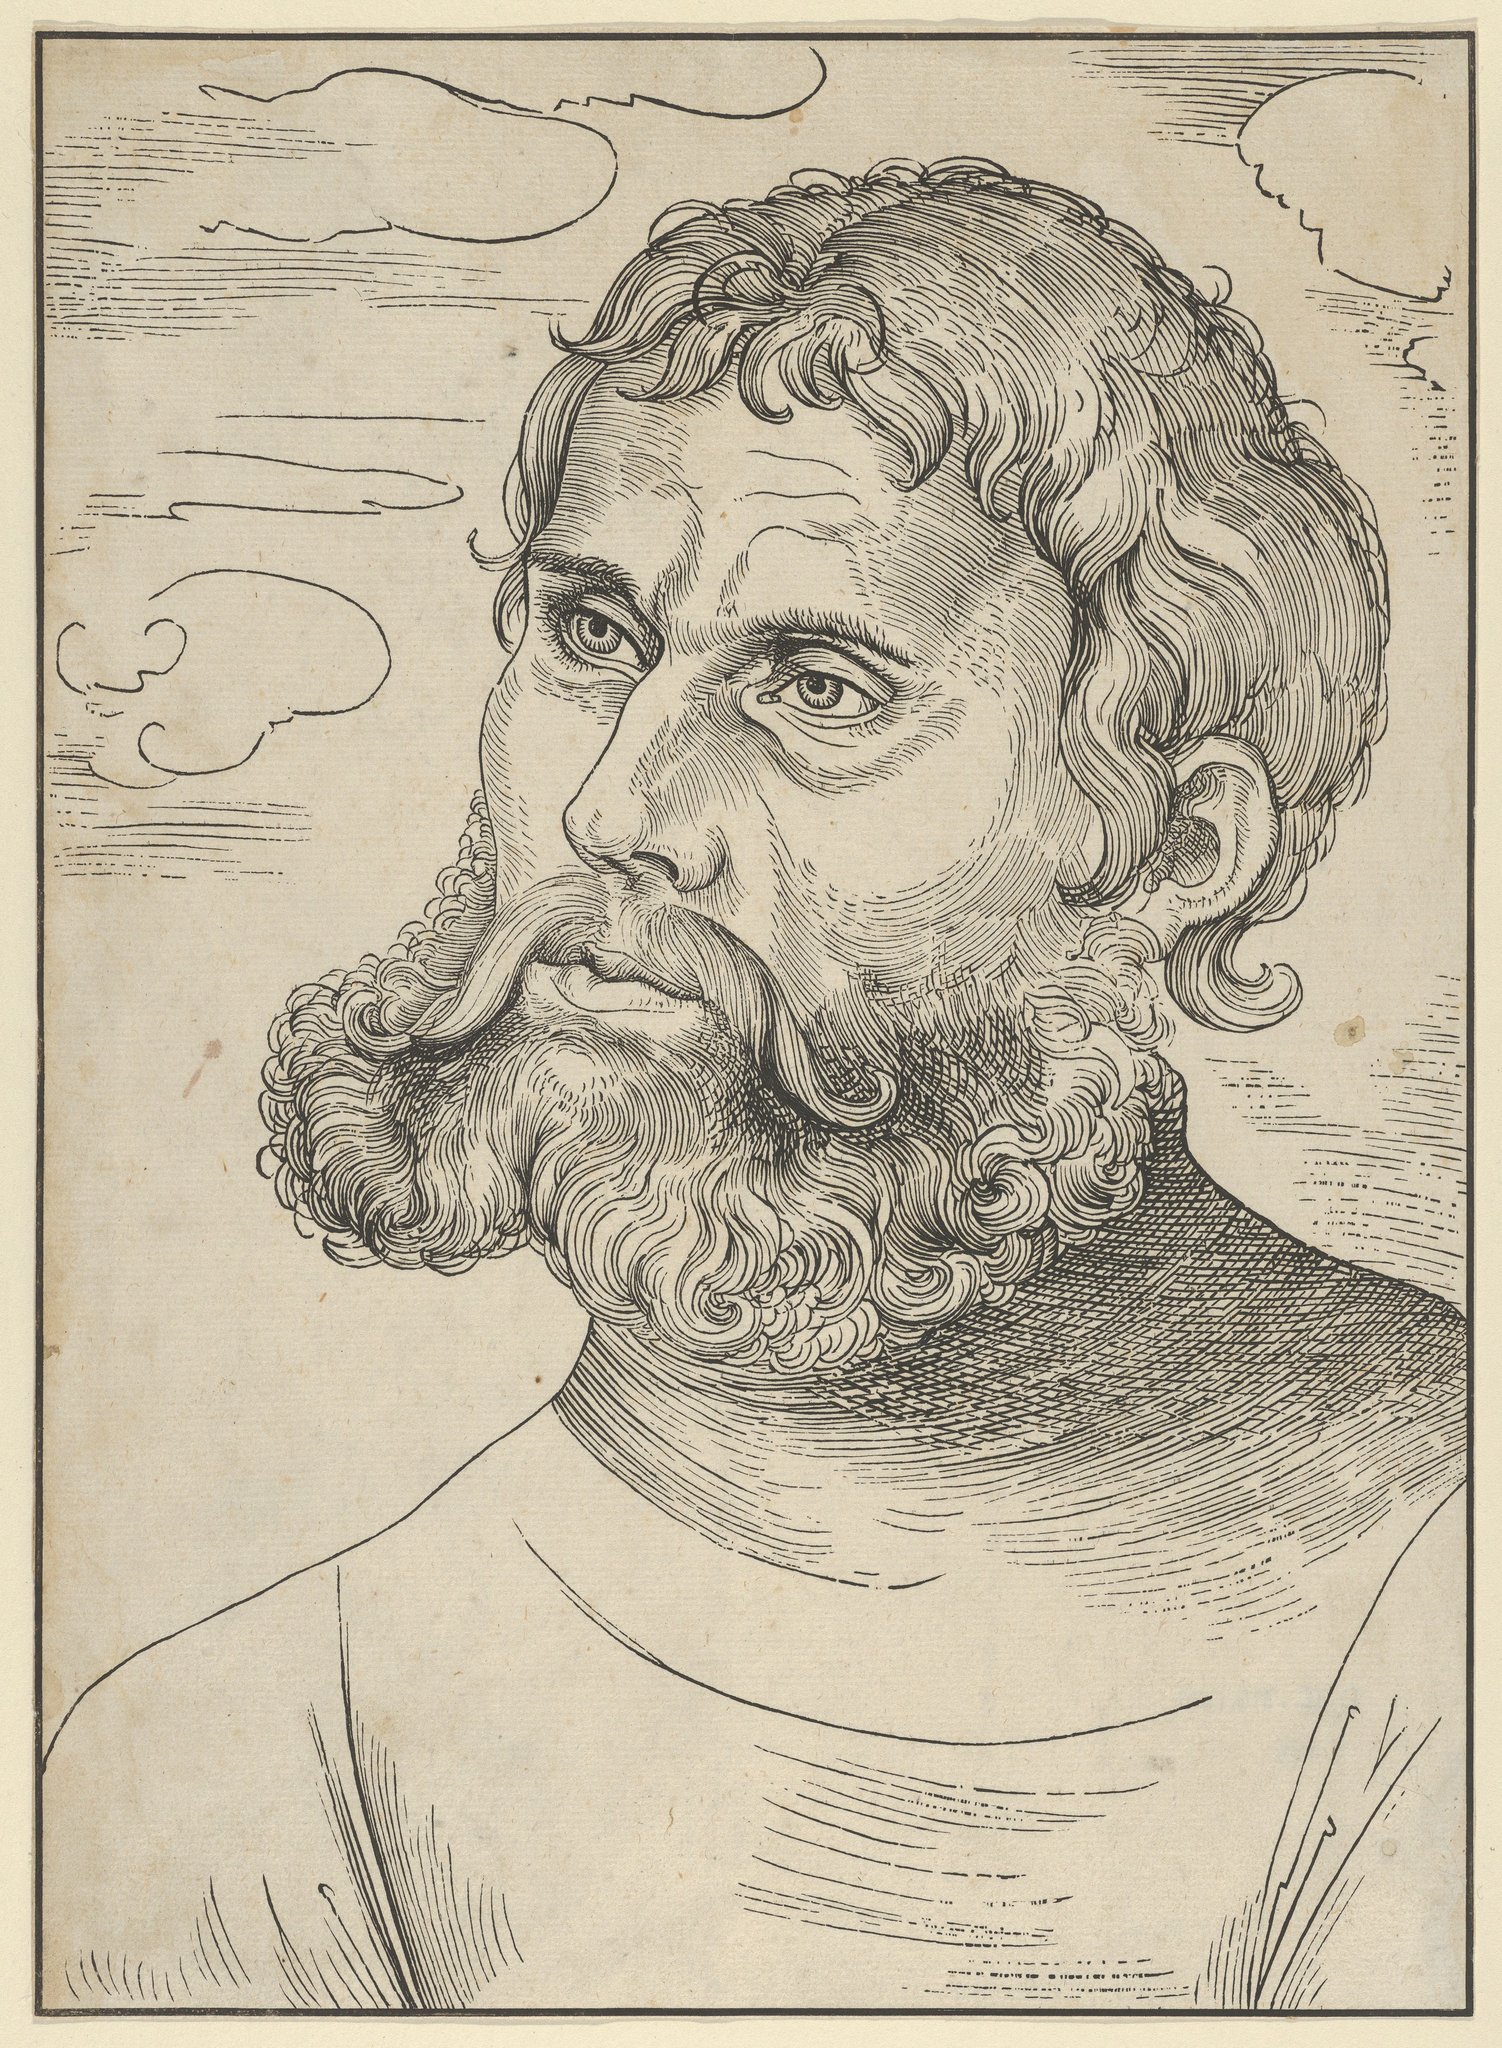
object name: print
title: Luther as 'Junker Jorg'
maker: lucas cranach the elder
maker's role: artist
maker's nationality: german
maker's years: 1472-1553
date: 1522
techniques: woodcut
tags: martin luther,portraits